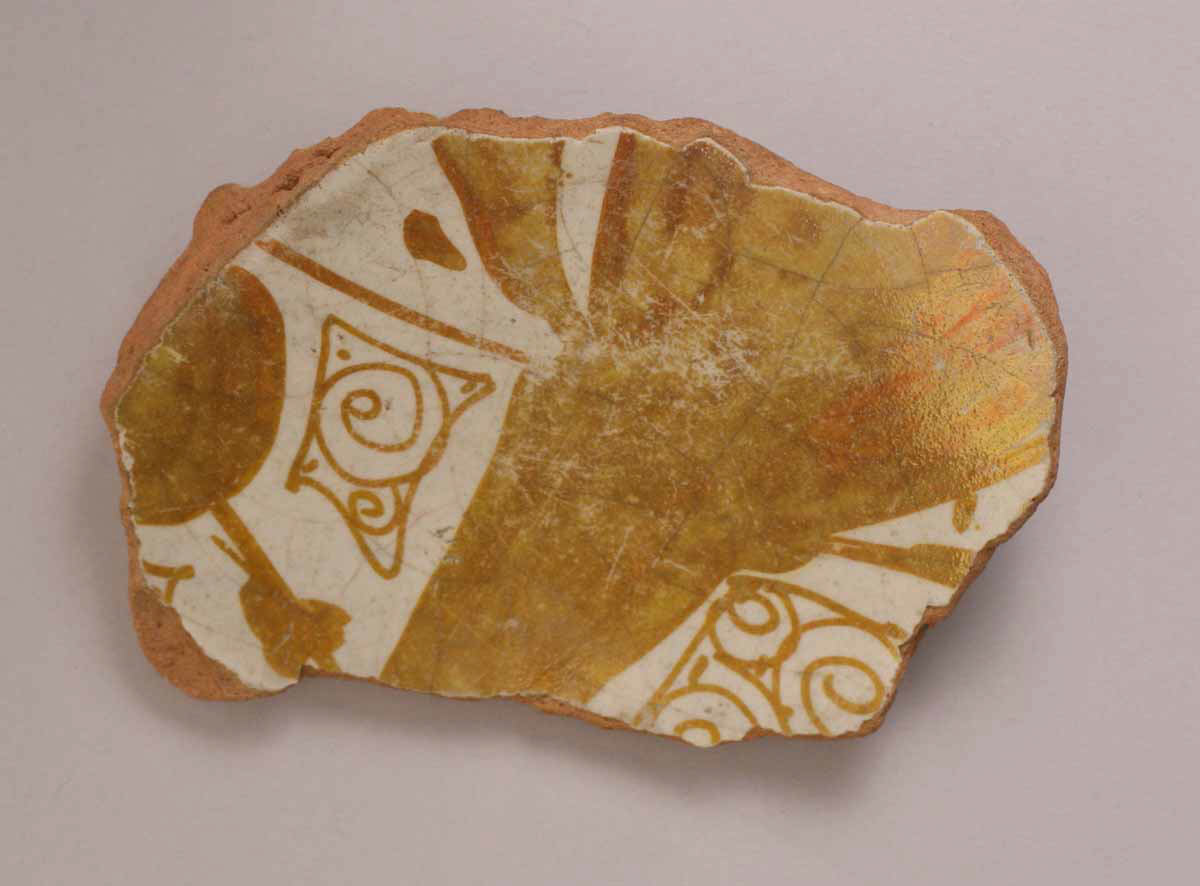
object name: ceramic fragment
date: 1001-1100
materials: earthenware, tin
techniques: enamel, luster painting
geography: egypt